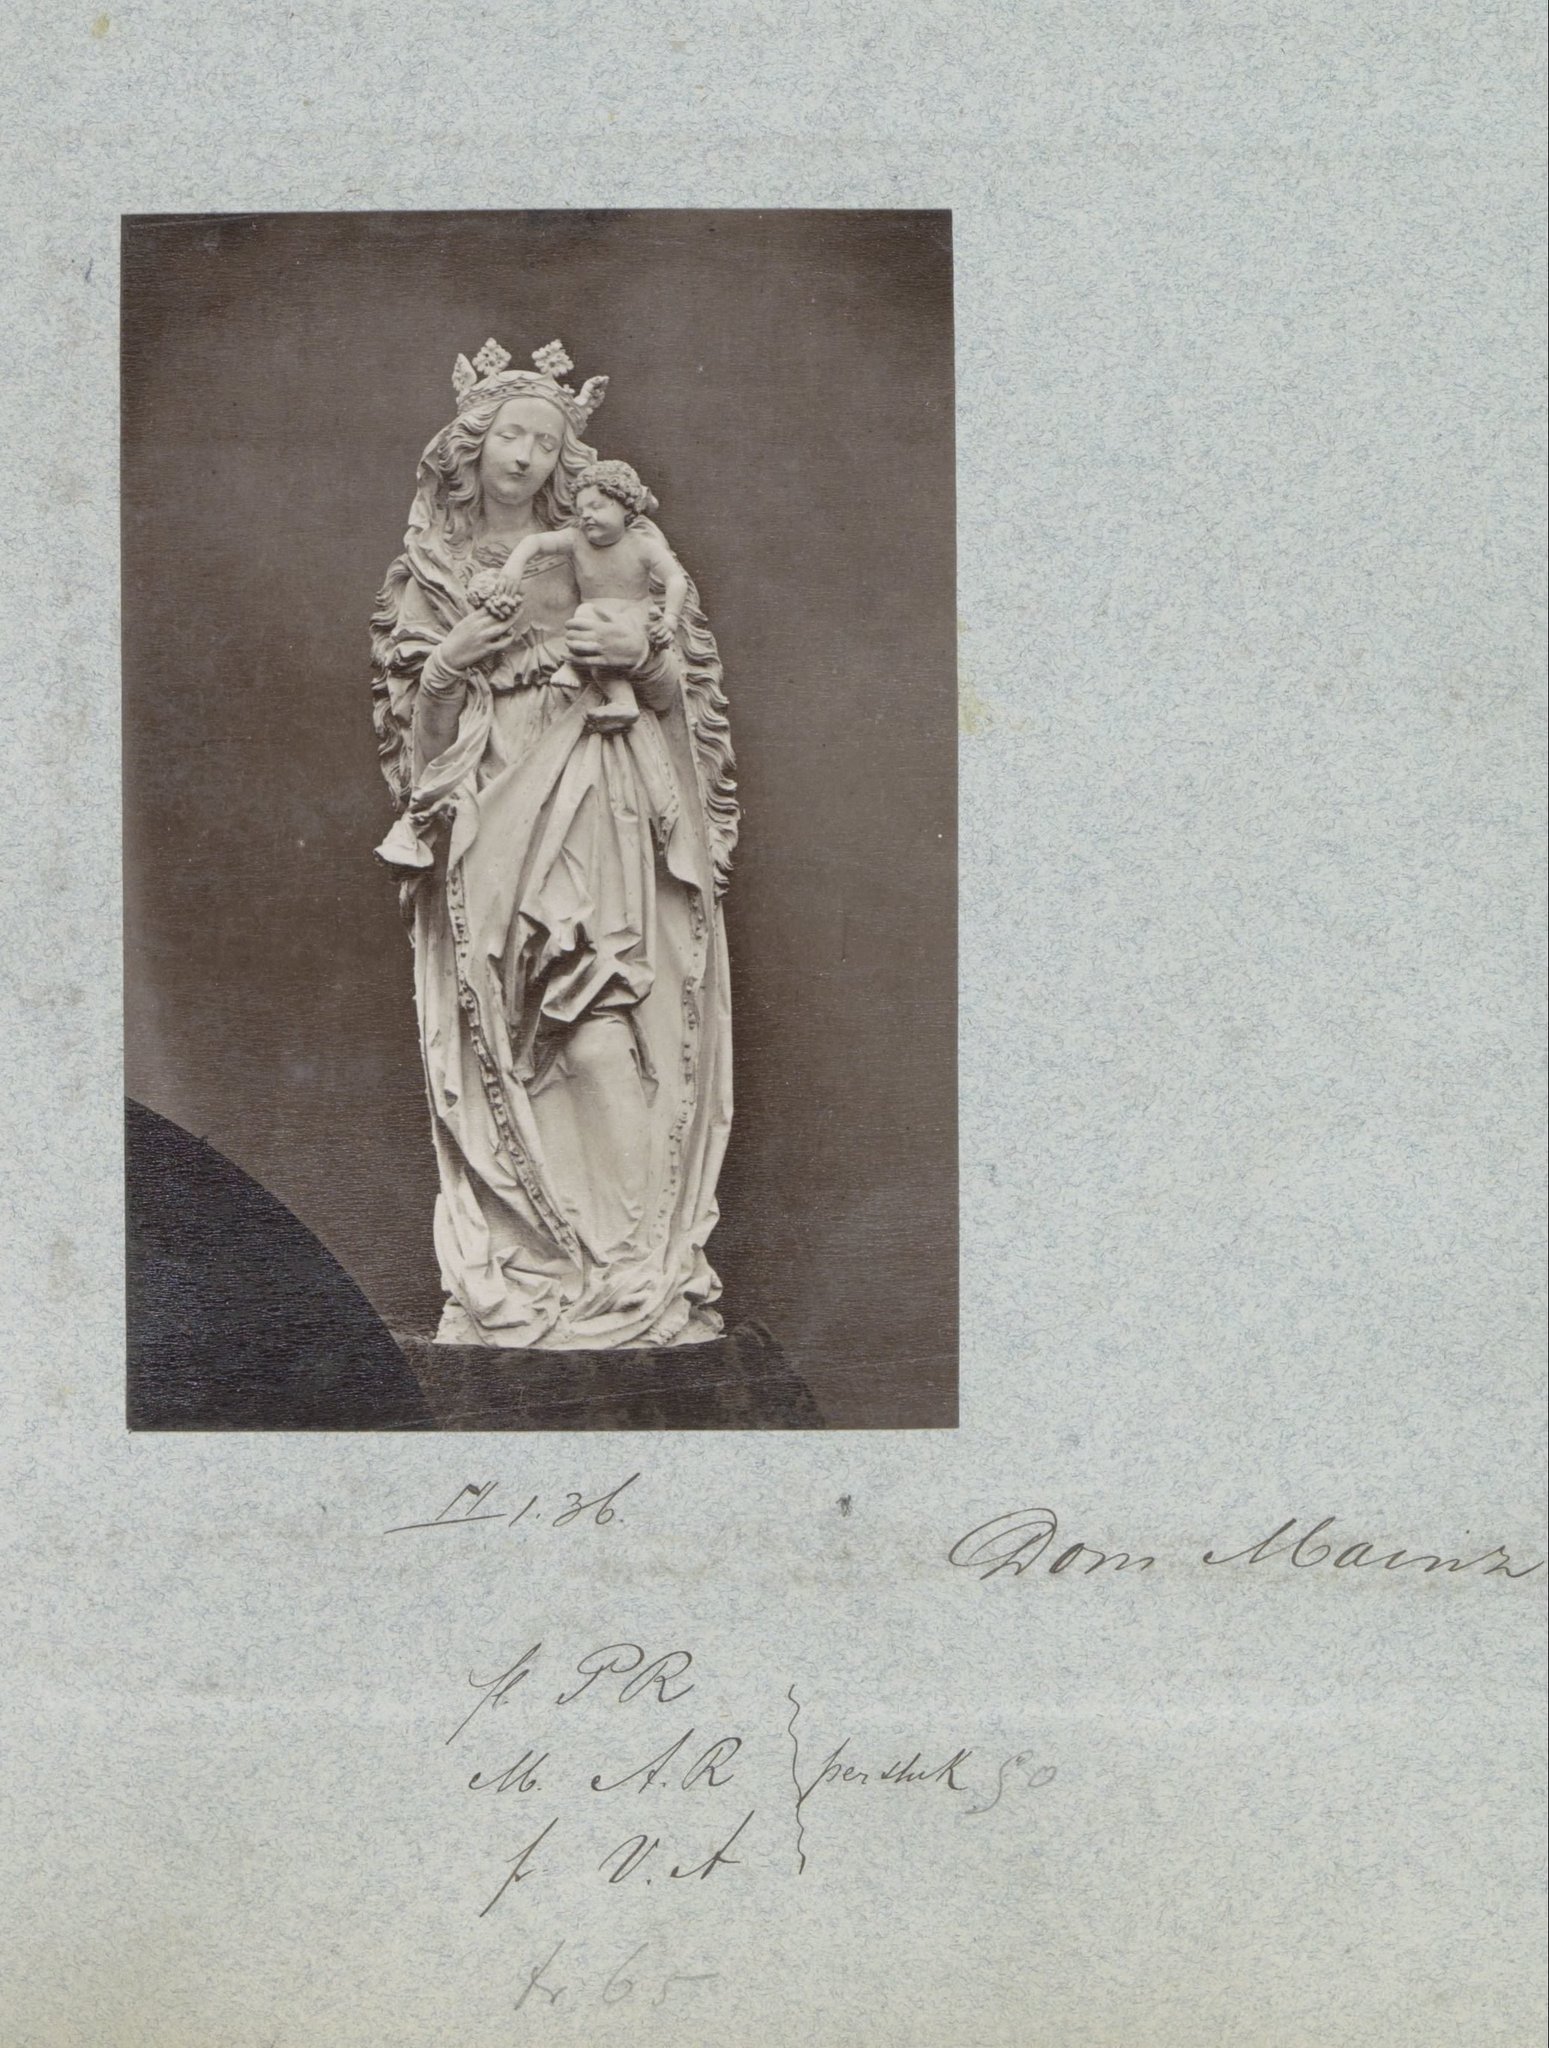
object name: album leaf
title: Sculptuur van een bisschop uit de Dom van Mainz, te Duitsland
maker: Anonymous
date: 1875-1900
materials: paper, photographic support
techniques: albumen print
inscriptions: annotation: ‘M 1.38’, annotation, annotation: ‘Dom Mainz / Er bestaan twee verschillende bisschoppen’